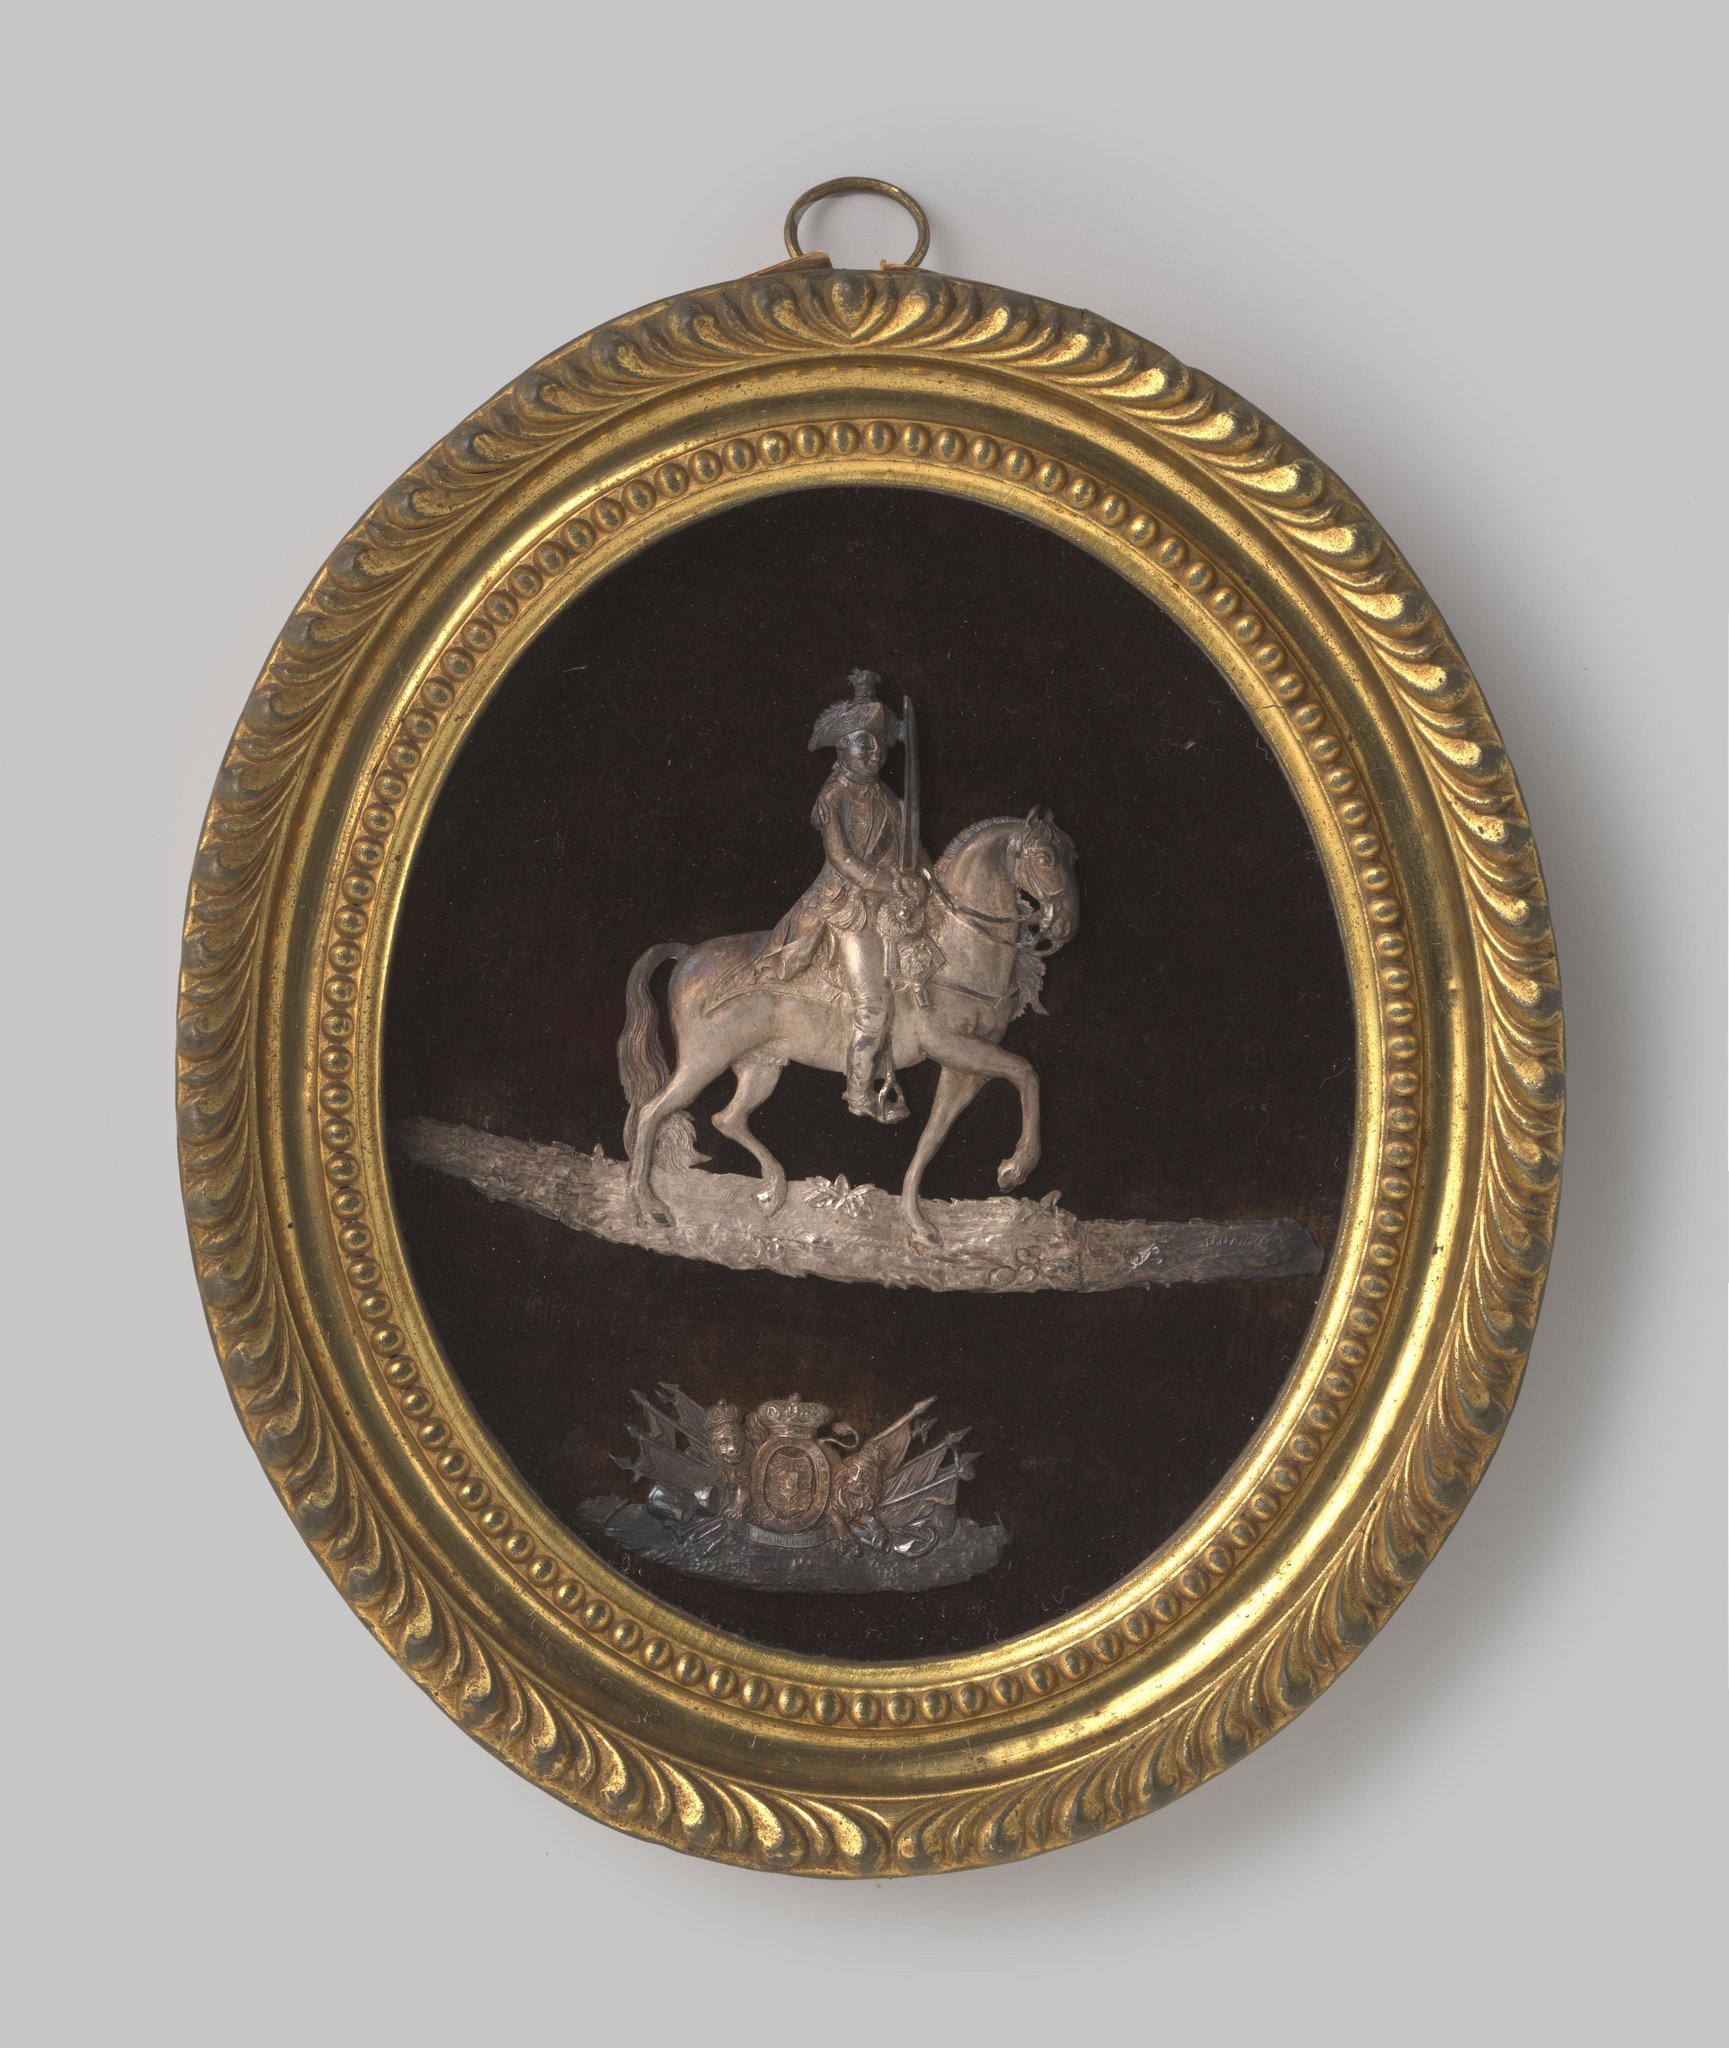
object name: ba relief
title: Basrelief van Willem V te paard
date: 1750-1800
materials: copper, glass, paper, silver, velvet, wood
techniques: woodworking, casting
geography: netherlands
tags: the hague, william v (prince of orange), netherlands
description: Zilveren basrelief van een figuur te paard naar rechts gewend, met getrokken zwaard in de rechterhand, op een zwart fluwelen fond. Onder een kleiner basrelief voorstellende een gekroond ovalen schild geflankeerd door leeuwen en omgeven door een wapentrofee. Het geheel in een ovaal, verguld houten lijstje achter glas. Op de keerzijde het opschrift op een stuk papier, geplakt op hout, ook achter glas. Voorzien van een koperen draagring. Voorzijde opschrift op wapen: HONI SOIT QUI MAL Y PENSE. Keerzijde: WiLLM de Vde....